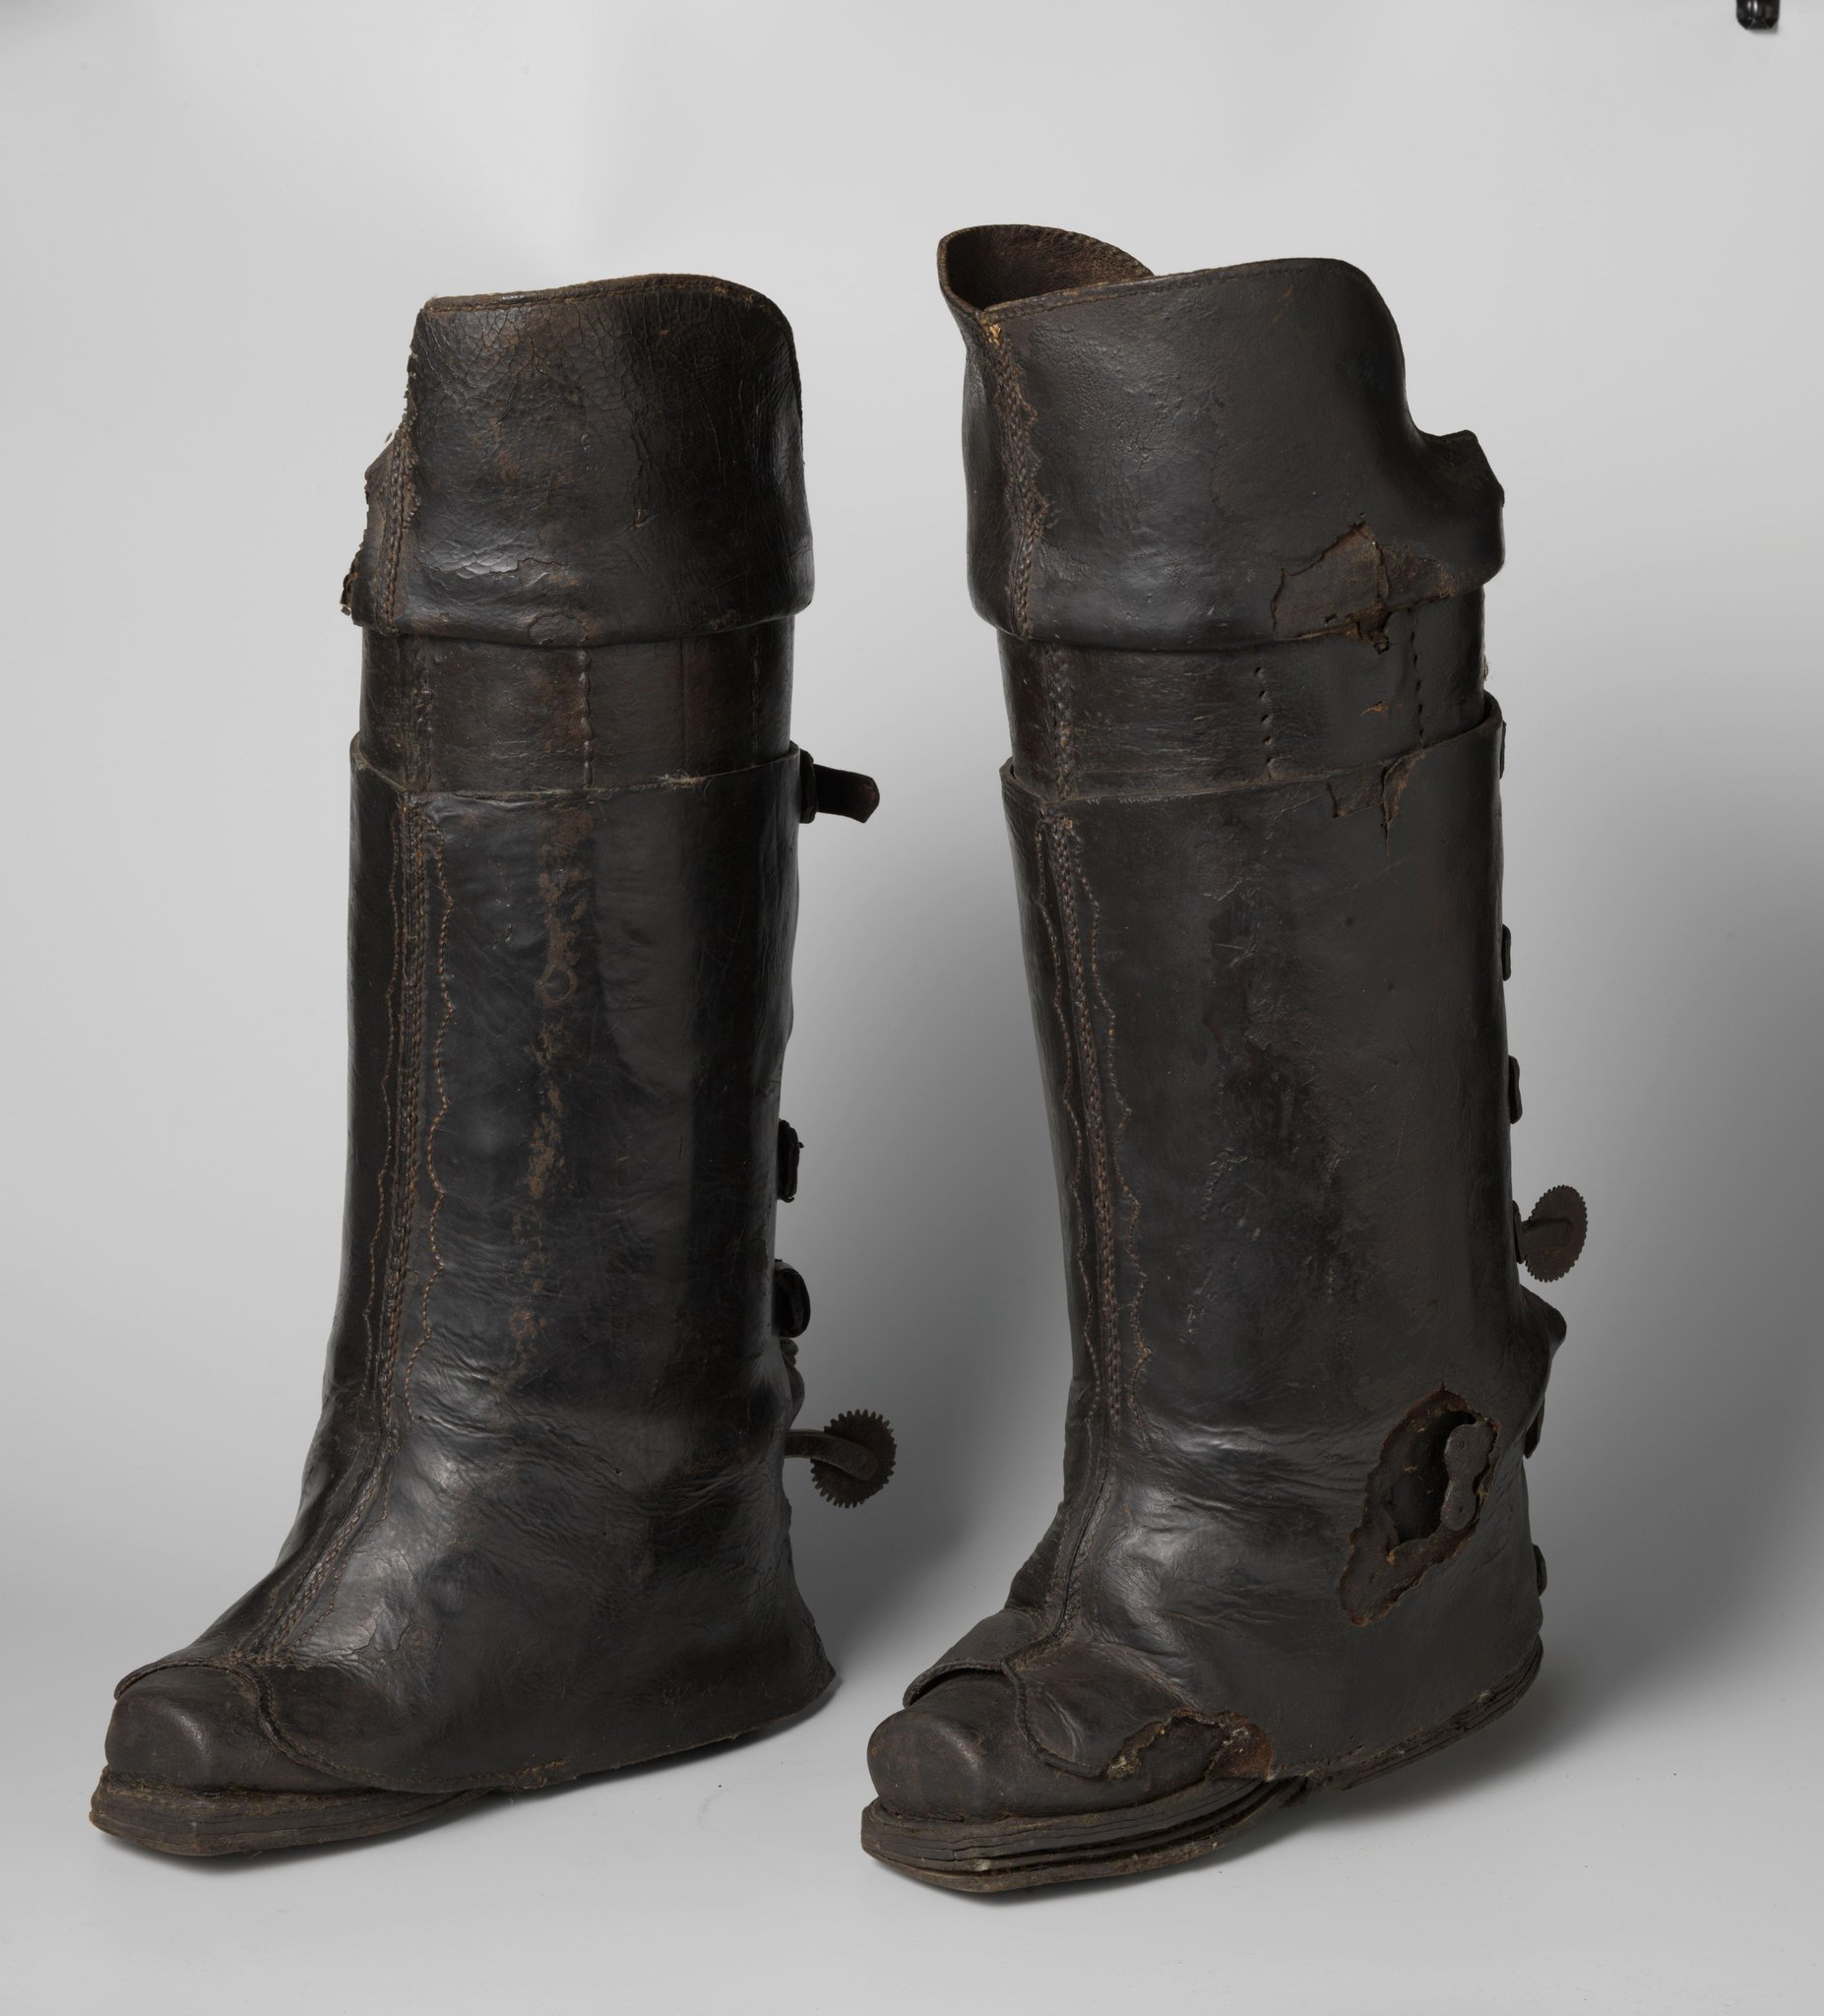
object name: menswear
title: Rechterpostiljonlaars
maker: Anonymous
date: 1775-1800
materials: iron, leather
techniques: cutting, forging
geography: netherlands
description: Rechterpostiljonlaars met sporen en een vlakke zool. Dubbele schacht, vastgezet met vijf gespen. Kniekap naar achteren laag uitgesneden. Deze laars heeft aan de buitenzijde een verticale band ter versteviging.